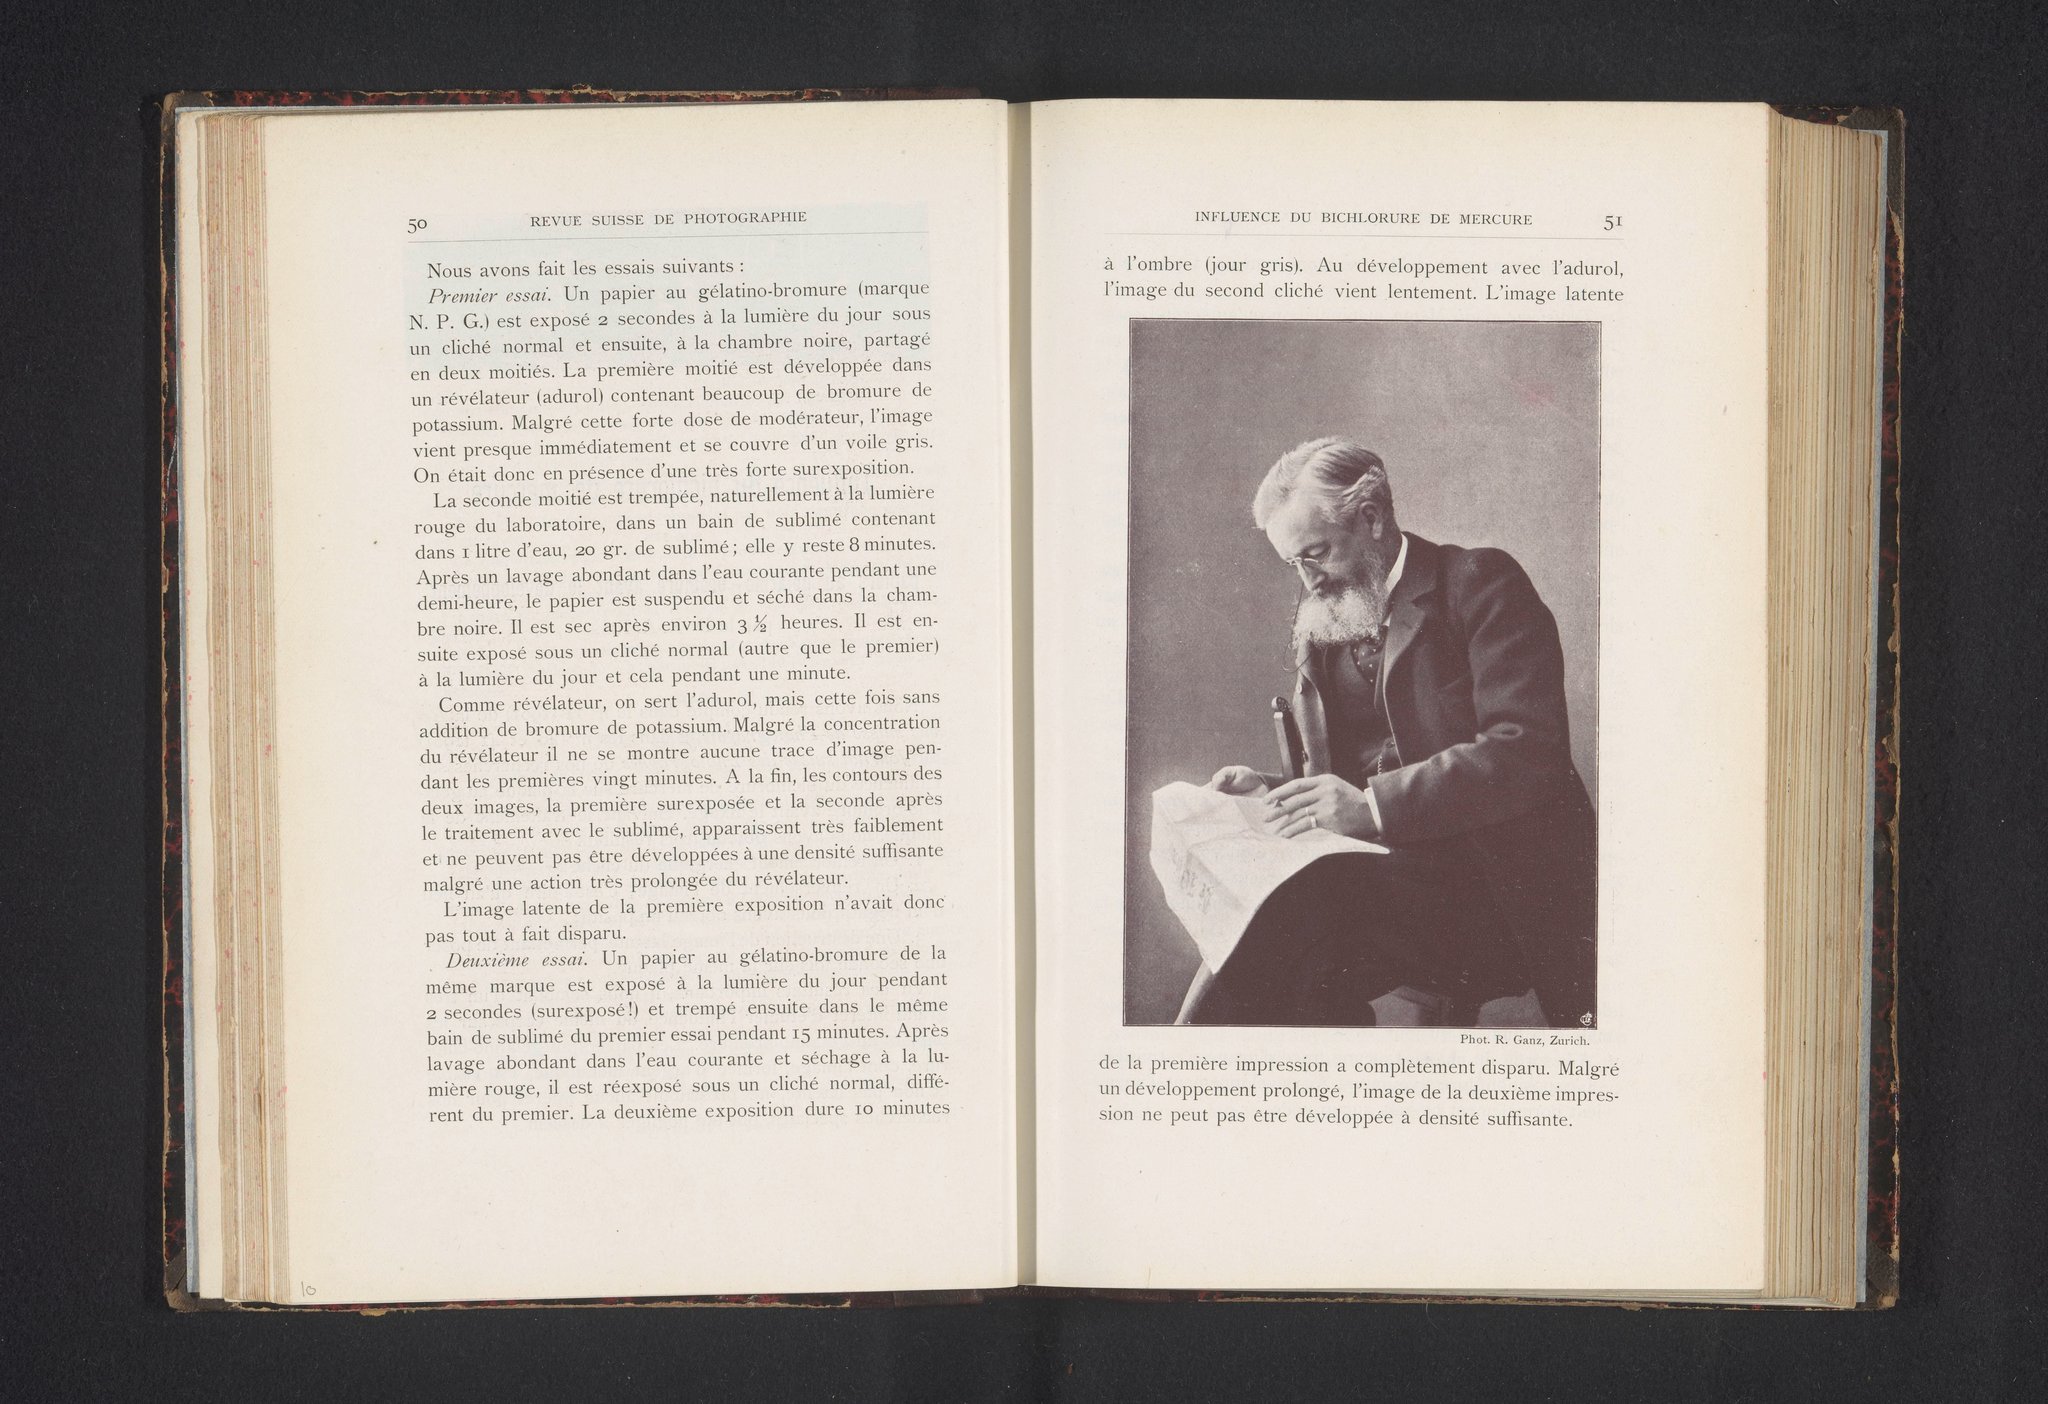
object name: photomechanical print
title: Portret van een onbekende man die de krant leest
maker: rudolf ganz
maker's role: fotograaf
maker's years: 1848-1928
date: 1897-1902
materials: paper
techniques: autotype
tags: sitting figure, historical persons, newspaper, news-sheet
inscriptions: monogram: ‘C. Cie’